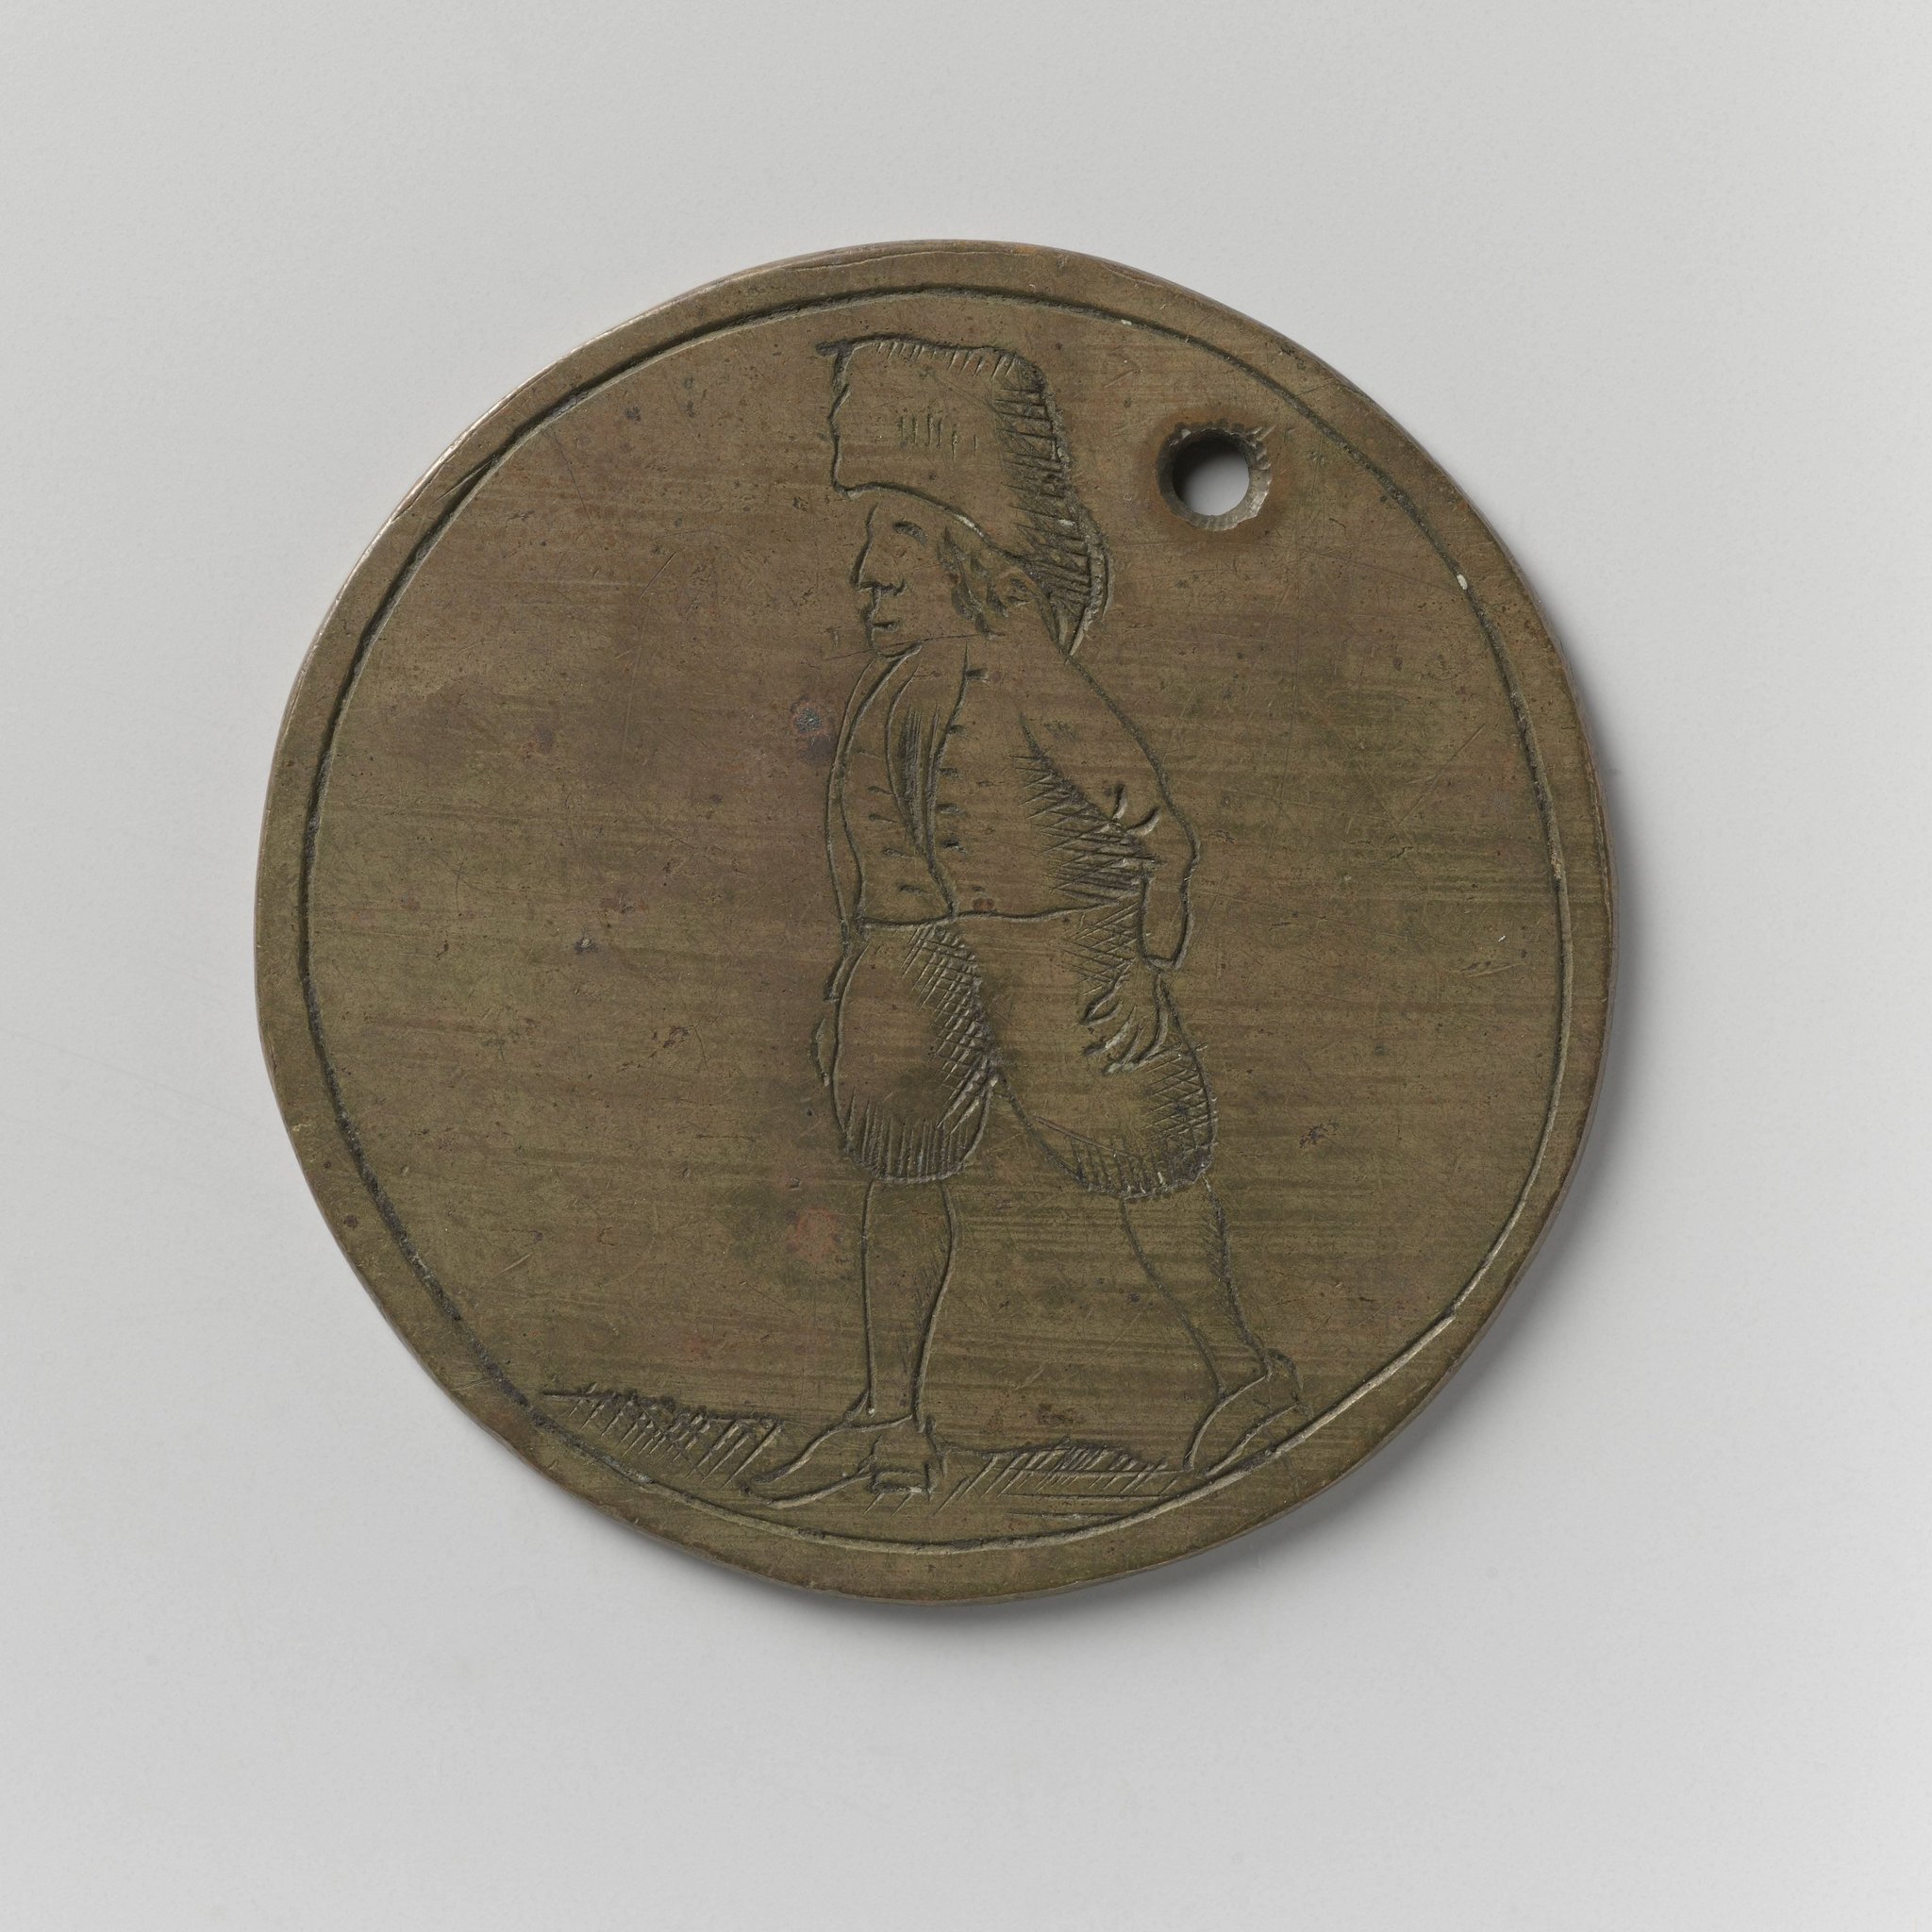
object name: medal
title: Korendragers- en -stortersgilde van Amsterdam, gildepenning van Harmen Klasen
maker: Anonymous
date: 1600-1800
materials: brass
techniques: engraving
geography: amsterdam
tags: amsterdam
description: Messing penning met gat erin. Voorzijde: naar links gewende man met last op hoofd. Keerzijde: opschrift